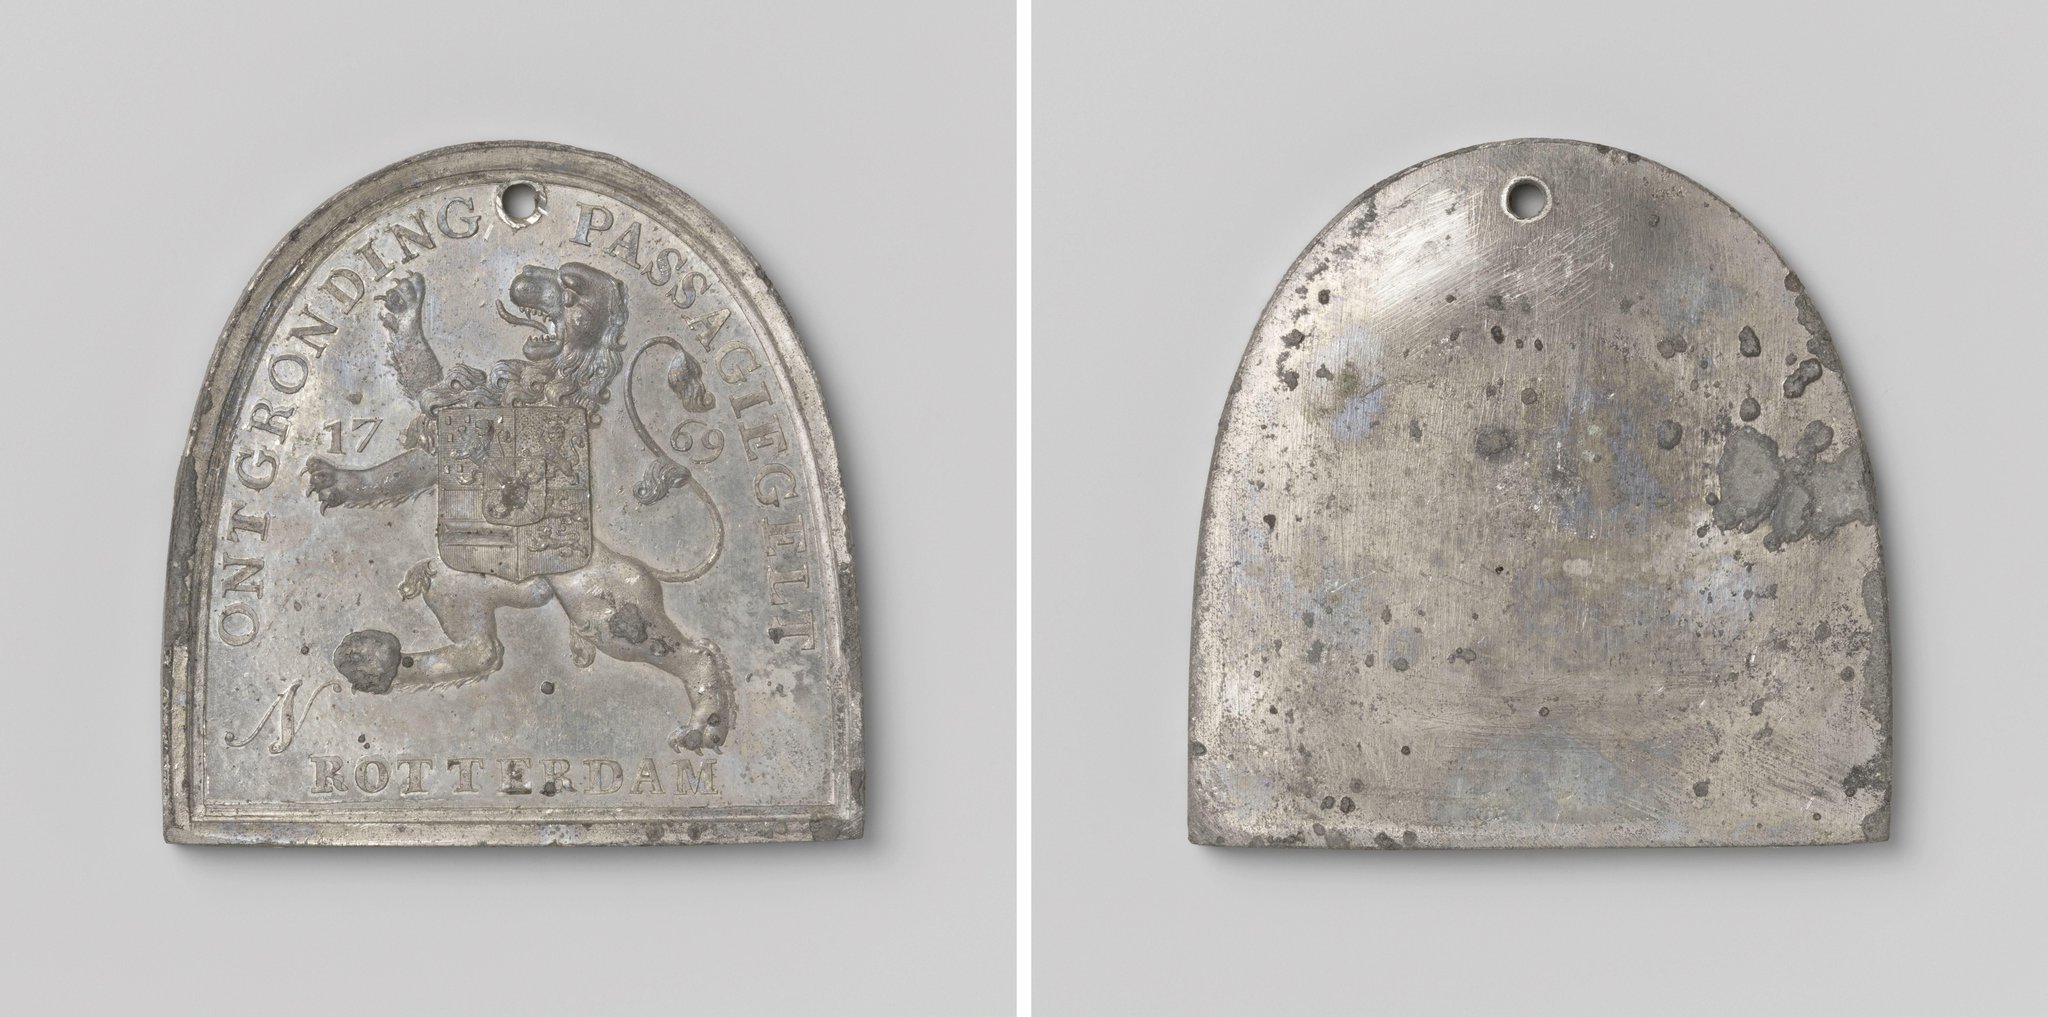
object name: identification medal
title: Ontgronding te Rotterdam, penning bedoeld als bewijs voor turfdragers, -vullers of -tonners om turf in te mogen voeren uit de nieuw ontgronde venen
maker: Anonymous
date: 1769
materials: lead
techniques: casting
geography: rotterdam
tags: rotterdam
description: Eenzijdige loden penning met ronde boven- en rechthoekige onderzijde, en gat erin. Voorzijde: staande leeuw met wapenschild op borst tussen jaartal binnen omschrift. Keerzijde: blanco.